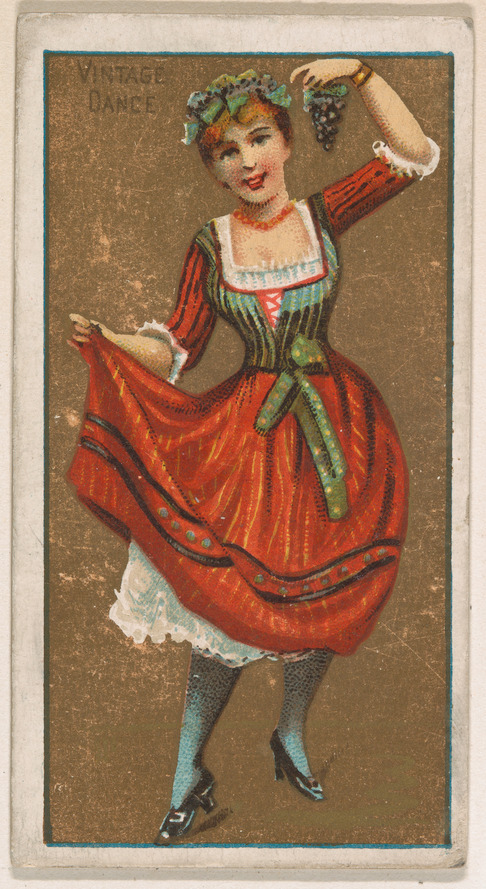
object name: print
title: Vintage Dance, from National Dances (N225, Type 1) issued by Kinney Bros.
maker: kinney brothers tobacco company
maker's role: publisher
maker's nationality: american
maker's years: 1869-2011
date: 1889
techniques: color lithograph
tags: dance,women,dancers